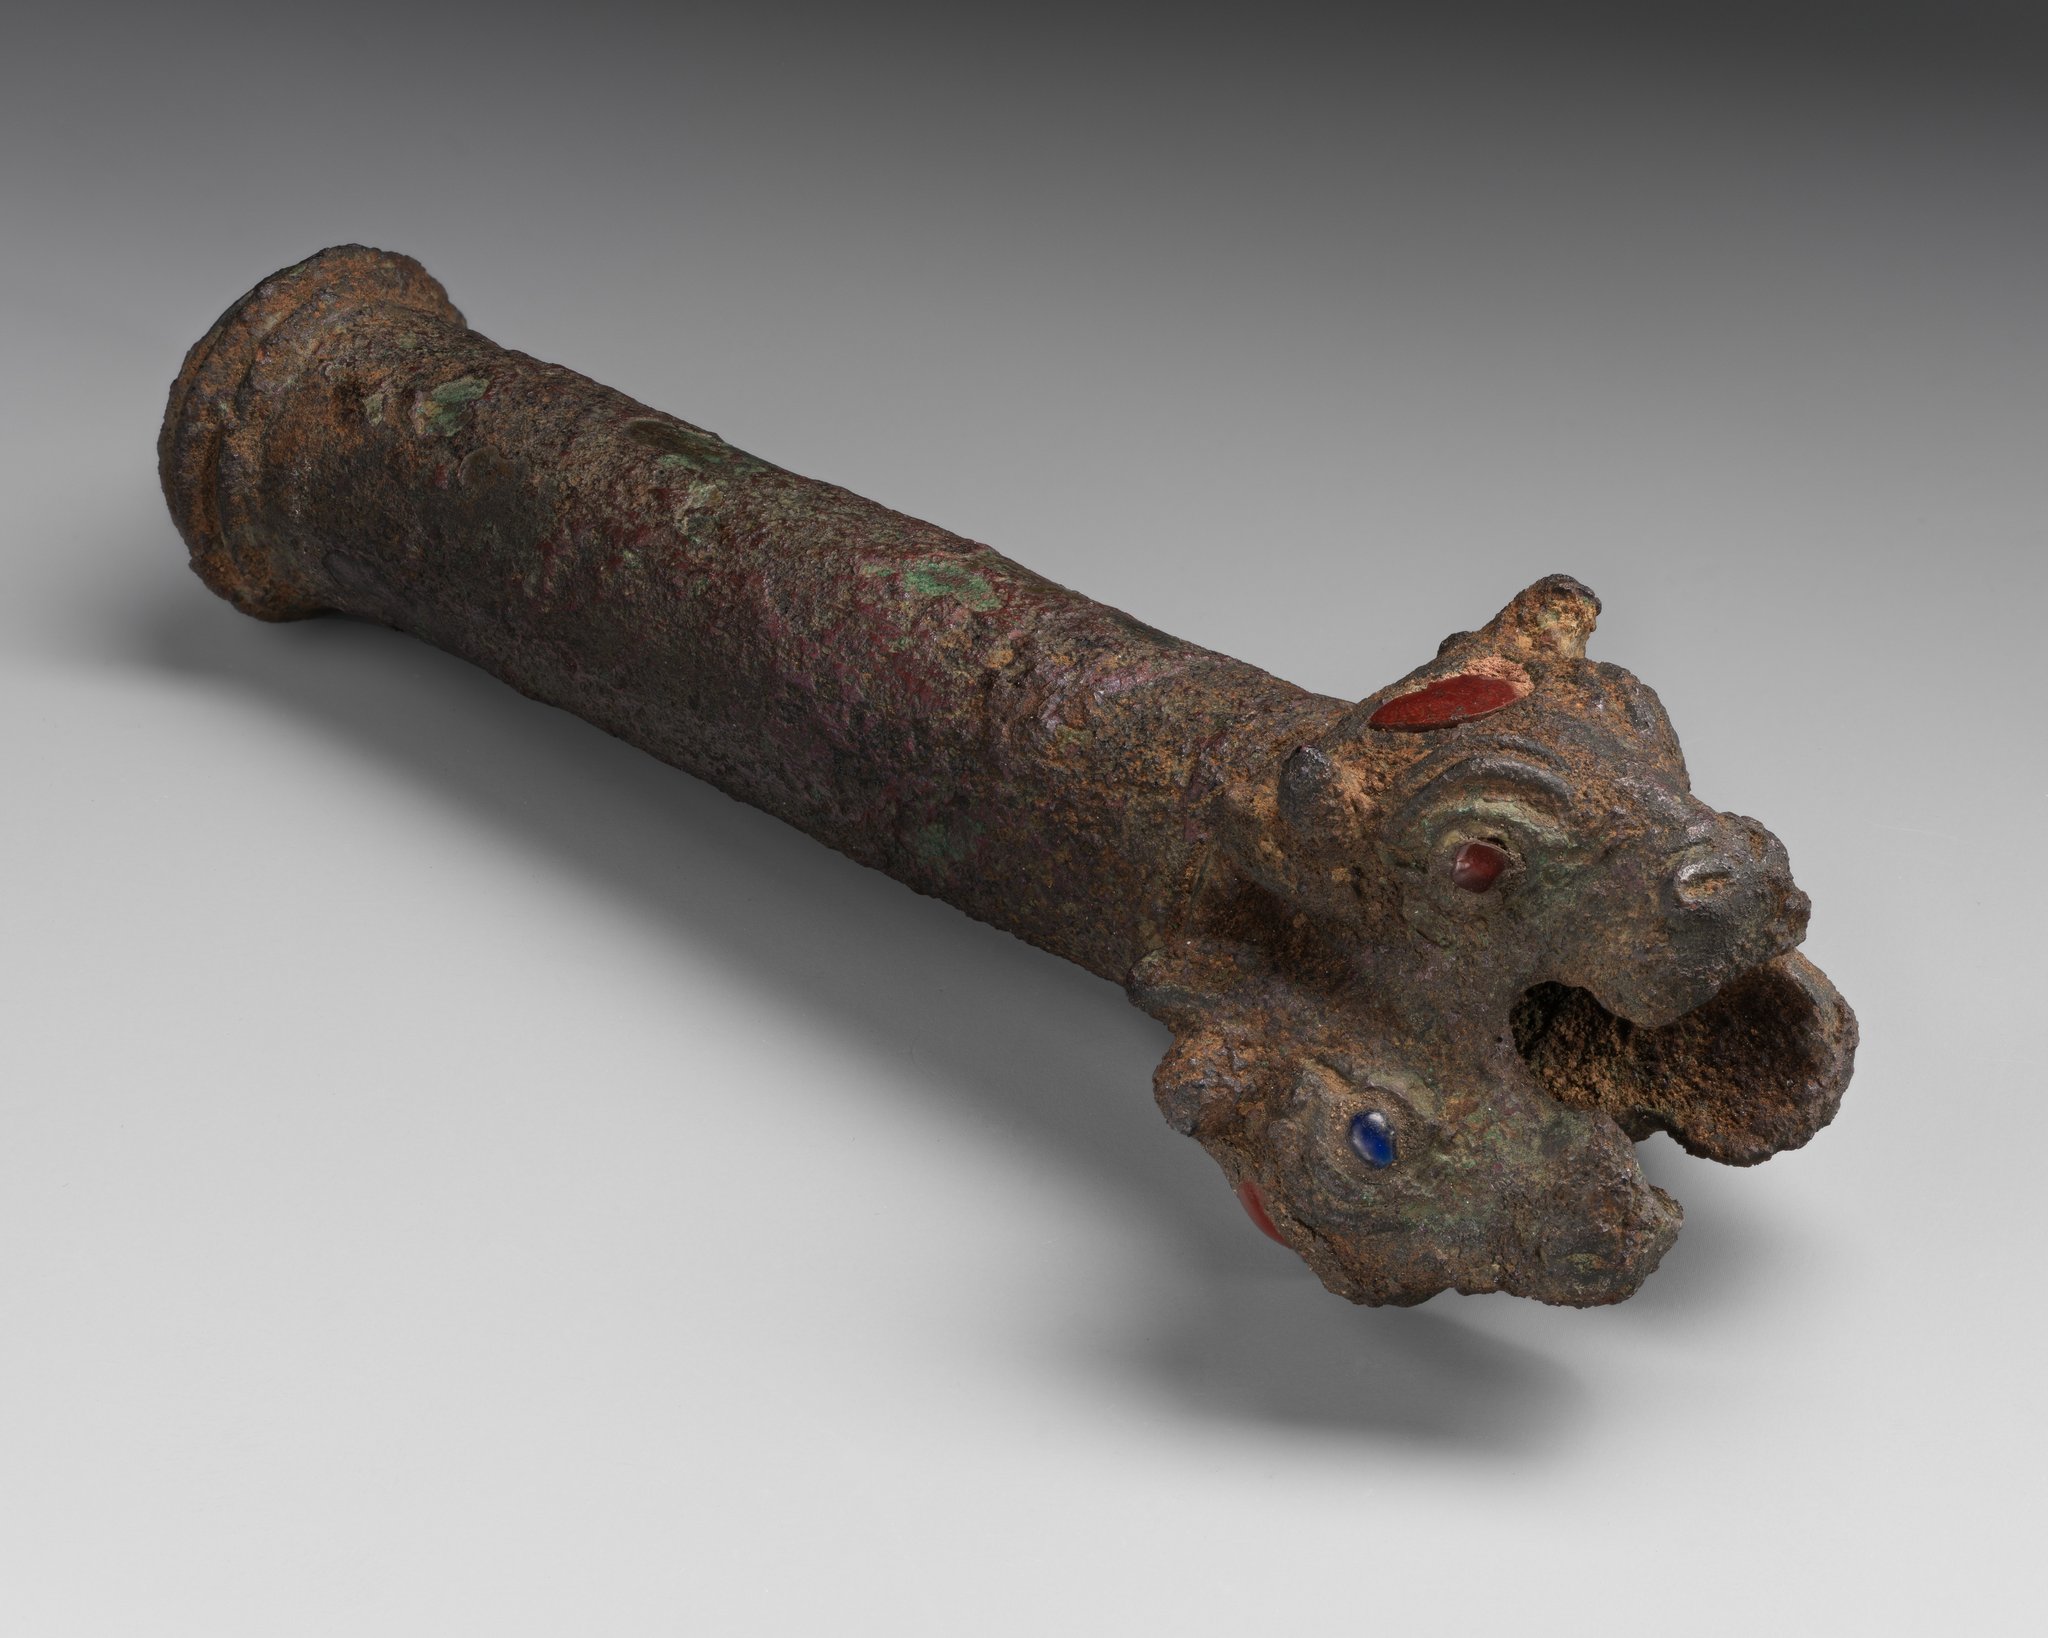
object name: scepter head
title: Tin-bronze scepter head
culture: cypriot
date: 1450-1050 BCE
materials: bronze, tin